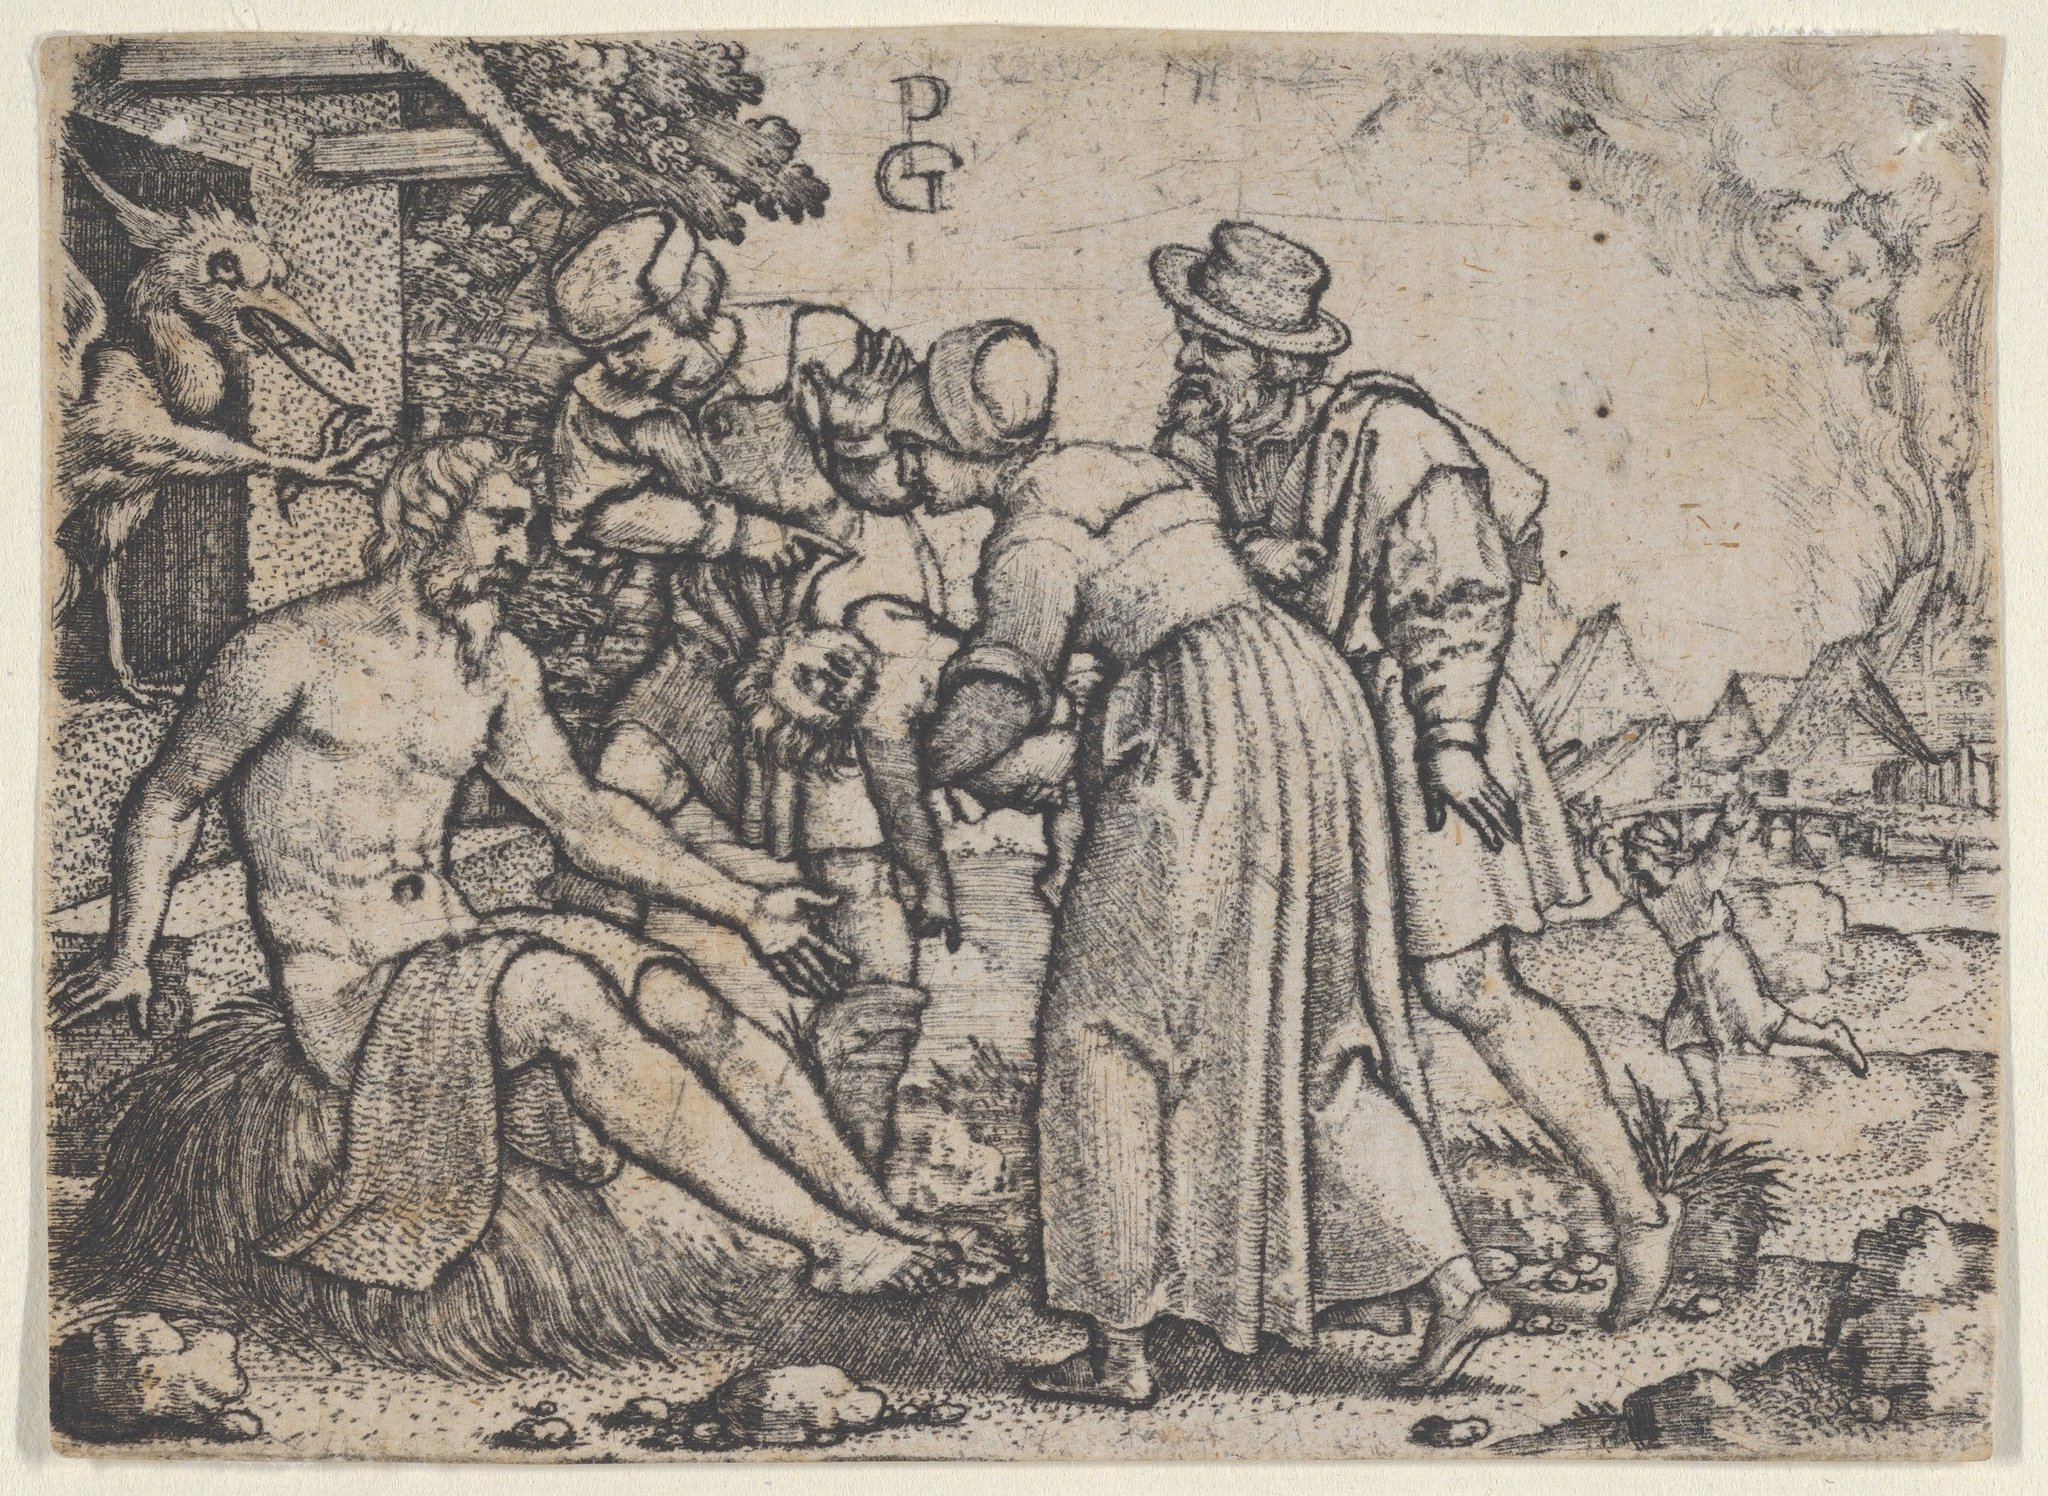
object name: print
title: The Persecution of Job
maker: georg pencz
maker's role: artist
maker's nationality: german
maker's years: 1500-1550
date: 1500-1550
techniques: engraving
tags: suffering,men,women,christ